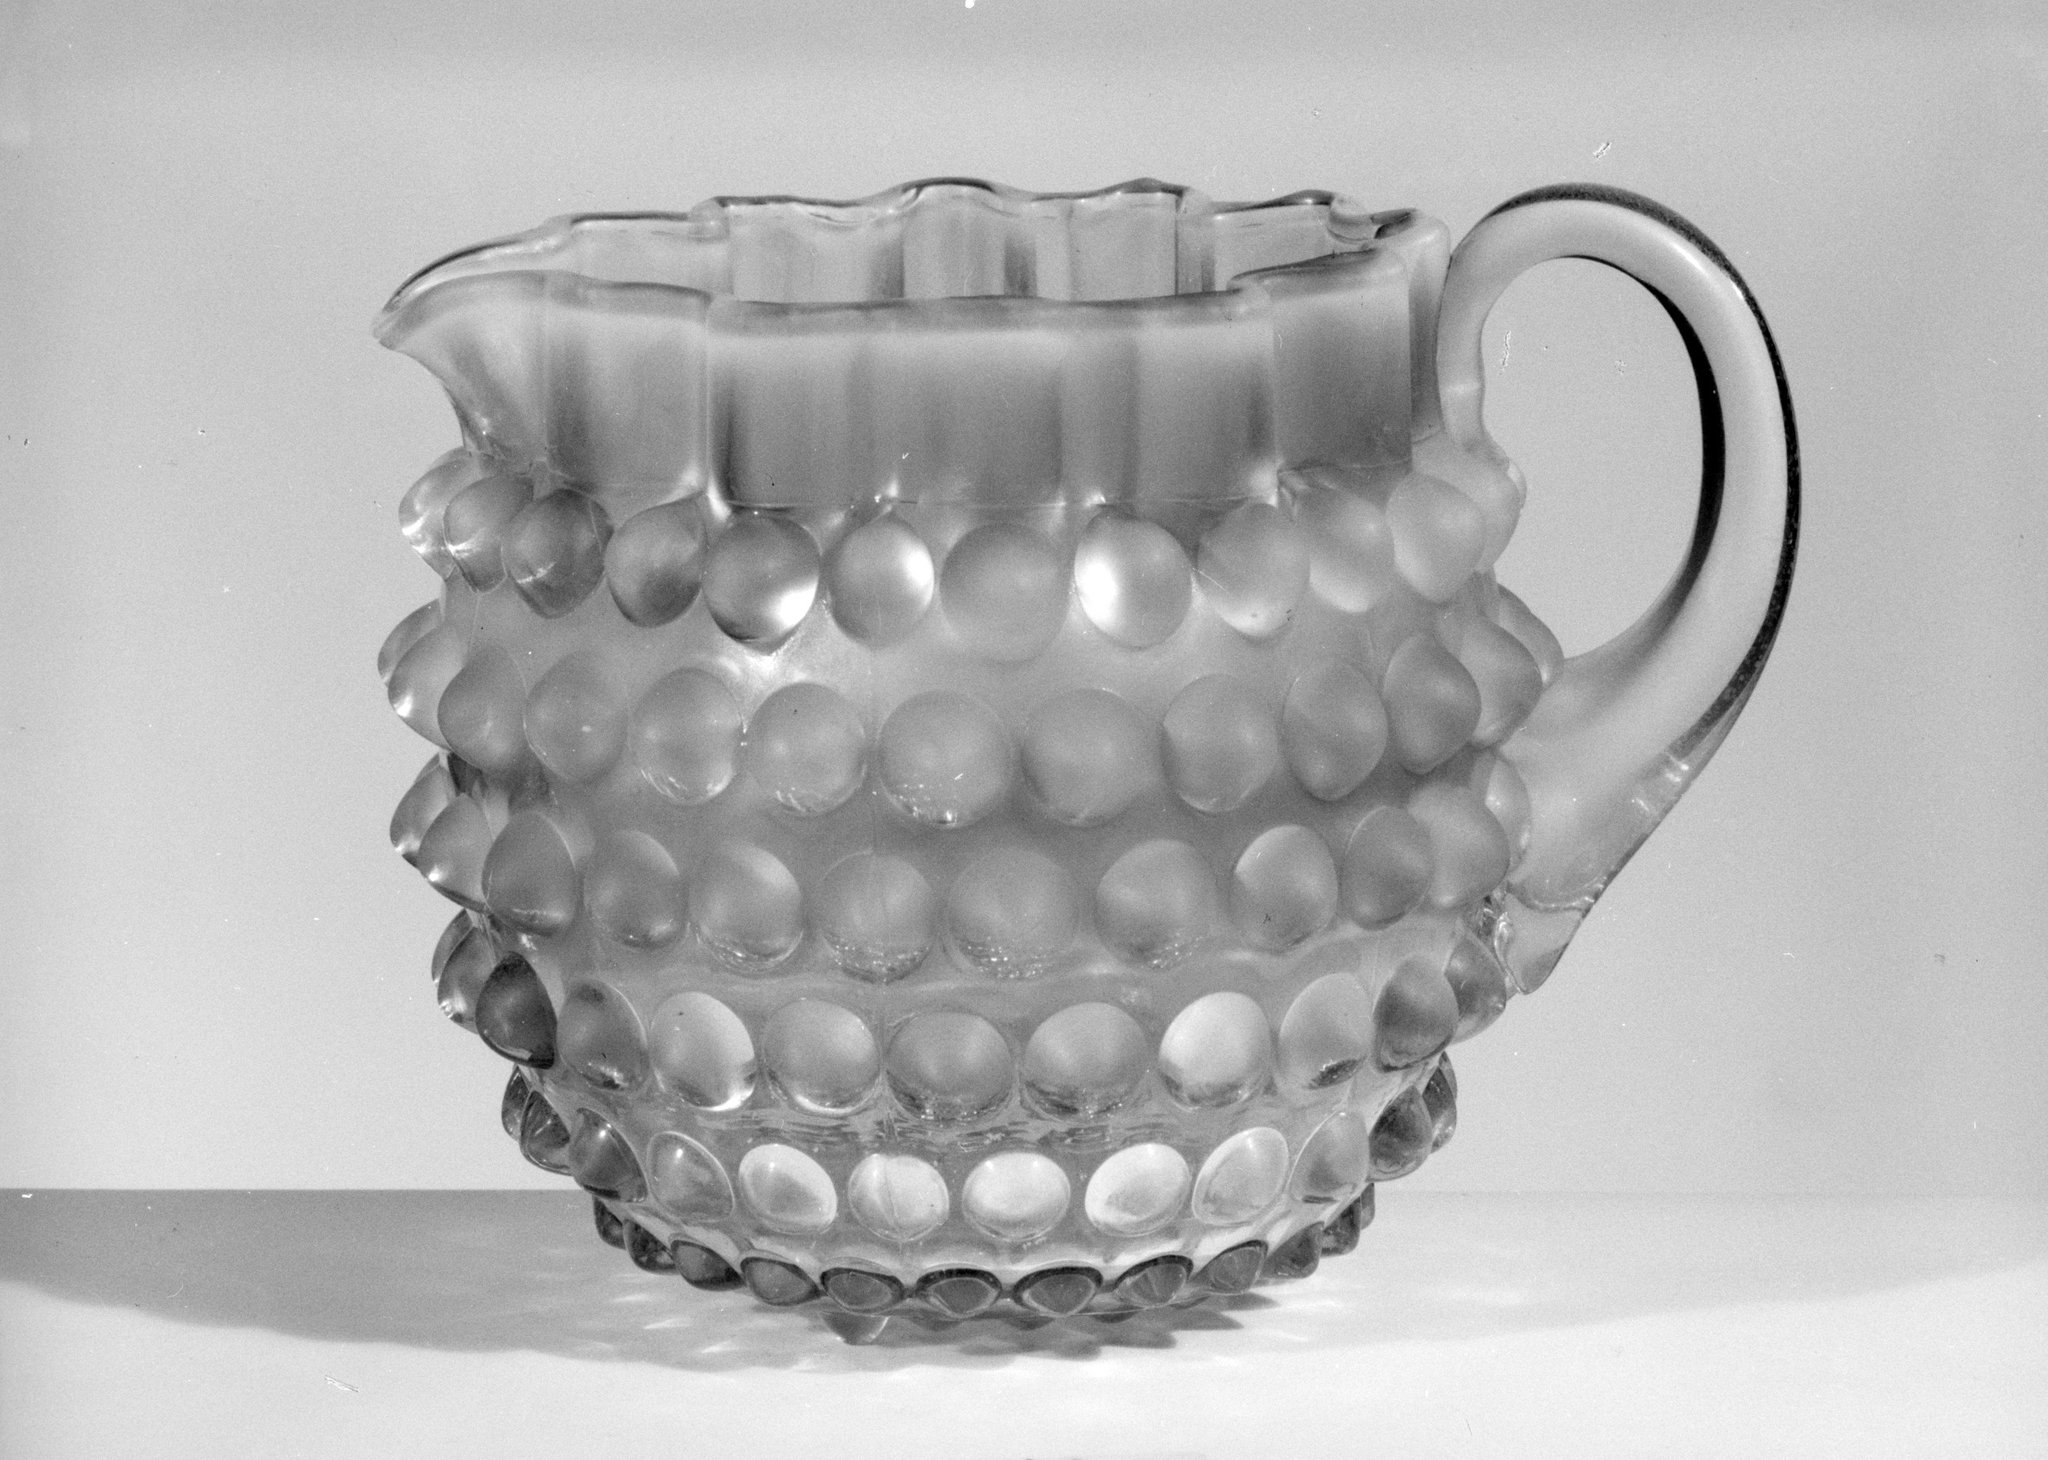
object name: pitcher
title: Hobnail Pitcher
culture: american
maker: hobbs, brockunier and company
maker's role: maker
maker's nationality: american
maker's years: 1863-1891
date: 1886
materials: glass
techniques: pressed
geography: united states